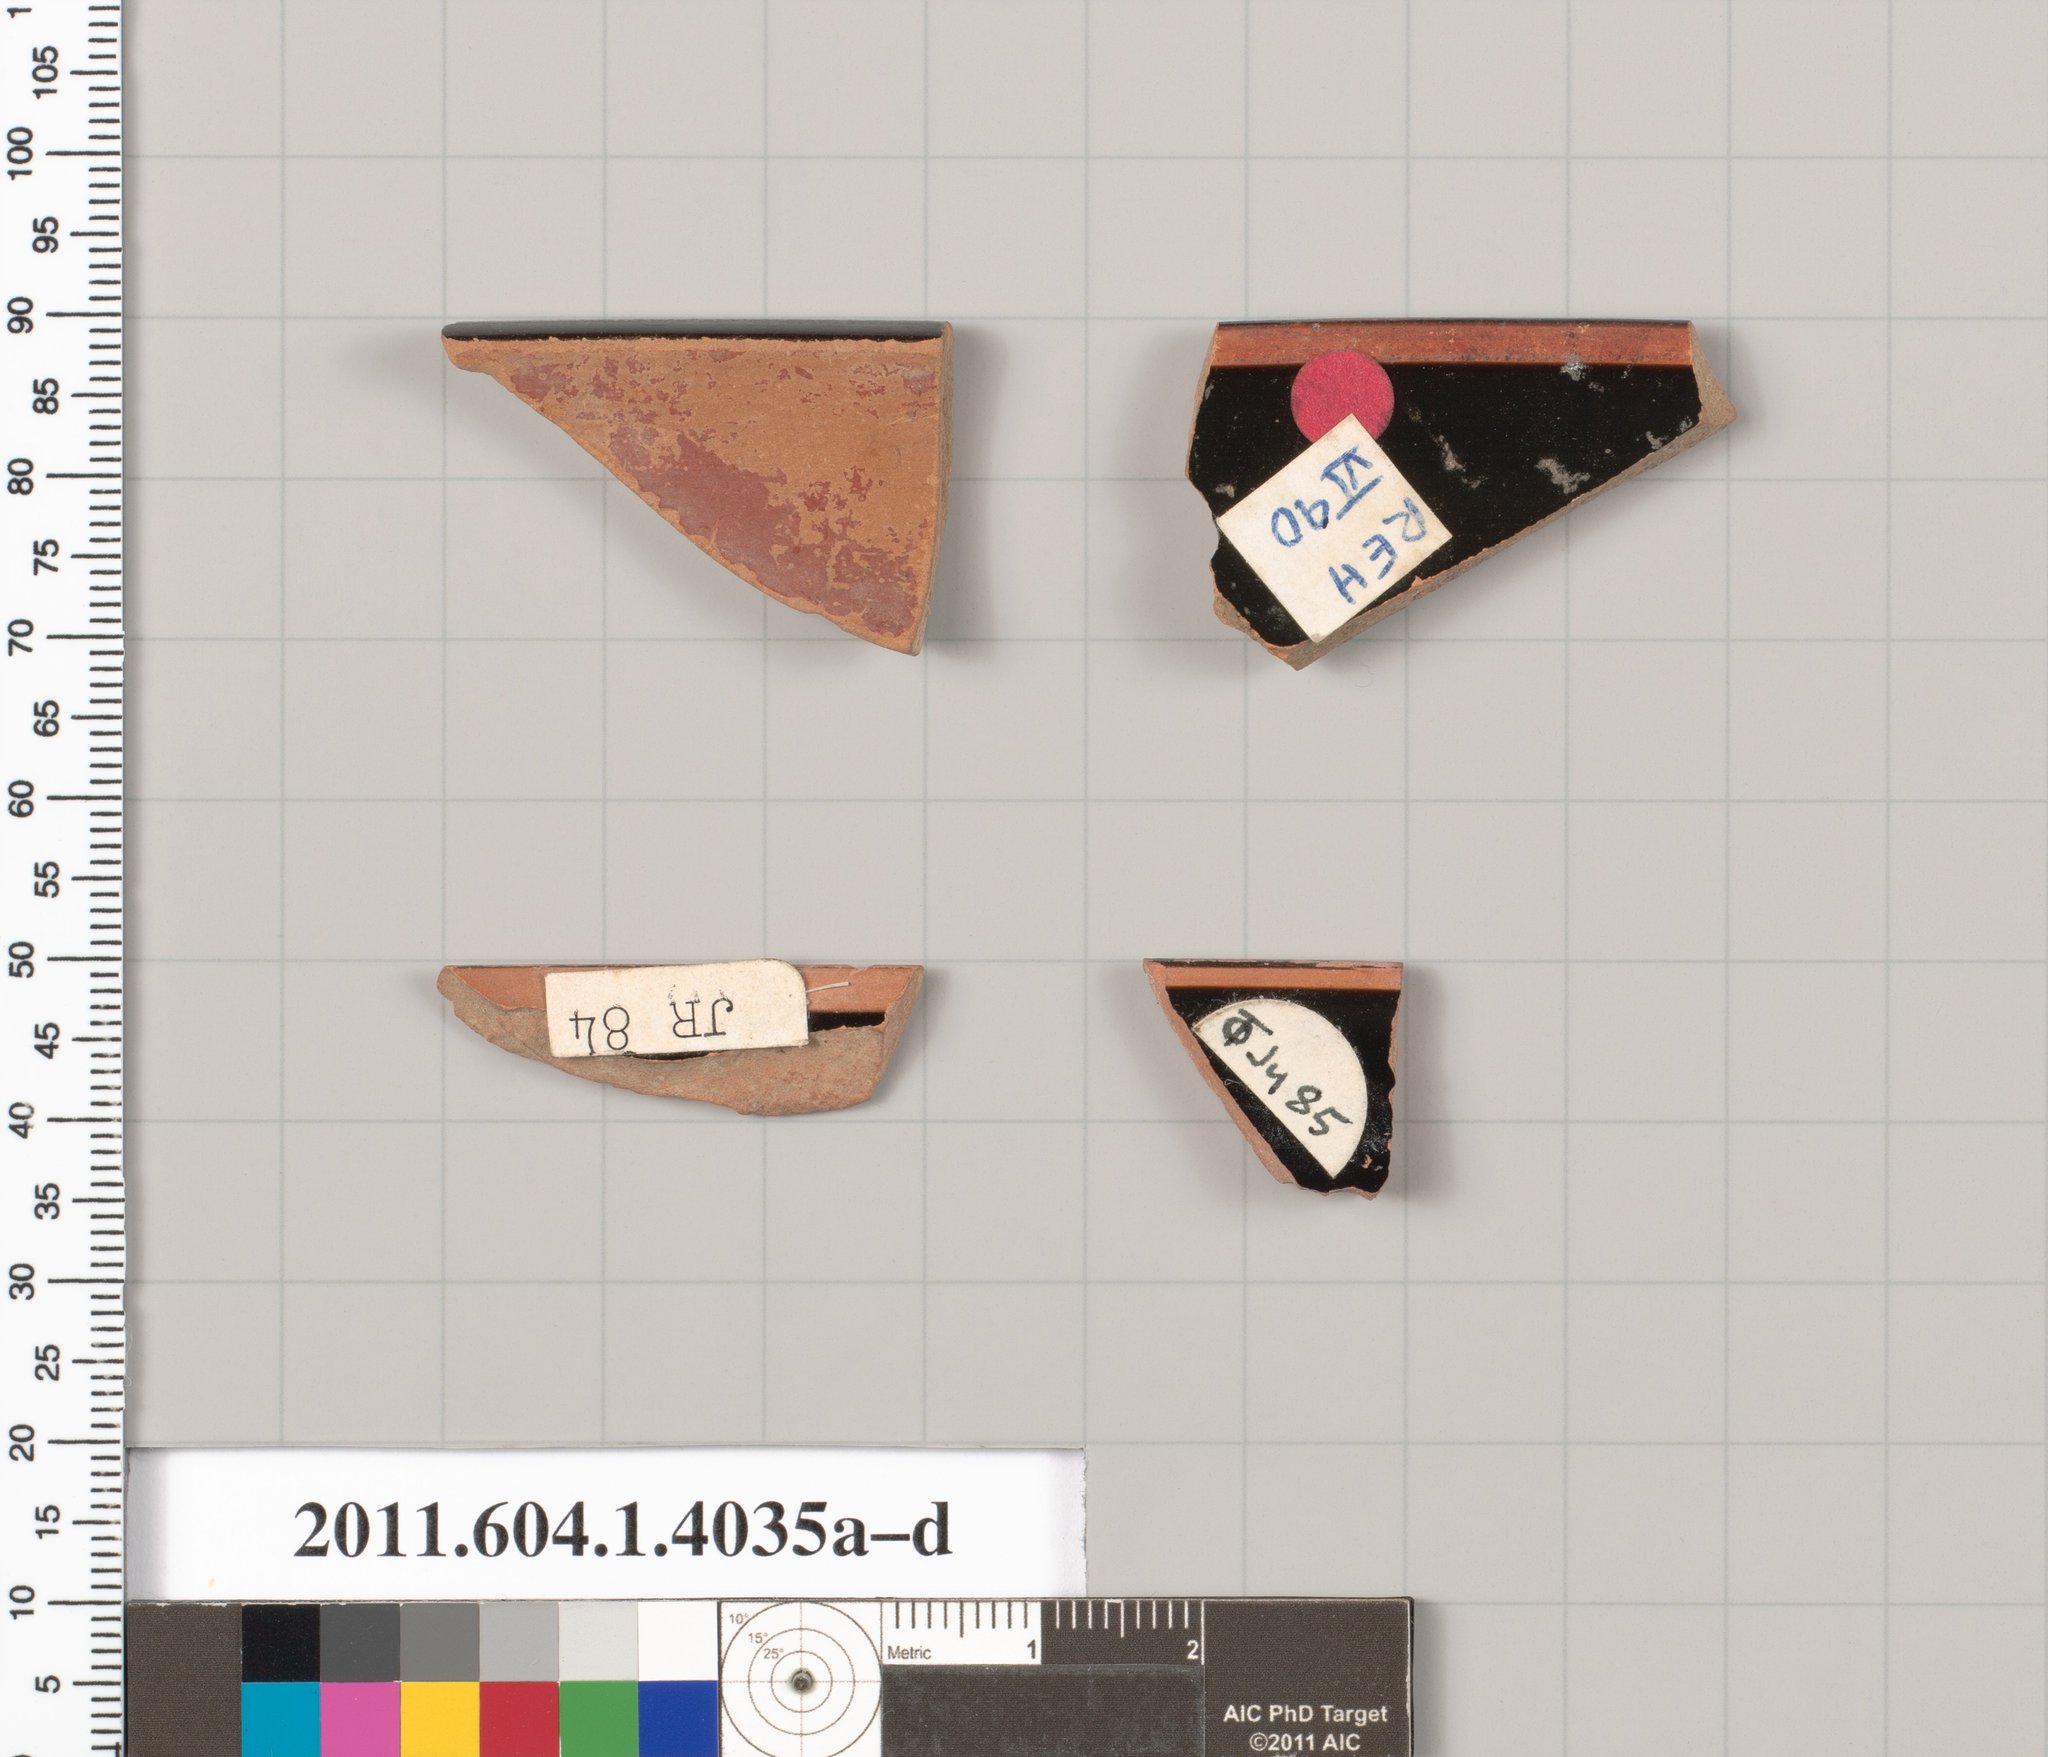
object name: kylix fragment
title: Terracotta rim fragments of kylikes (drinking cups)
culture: greek, attic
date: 460-440 BCE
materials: terracotta